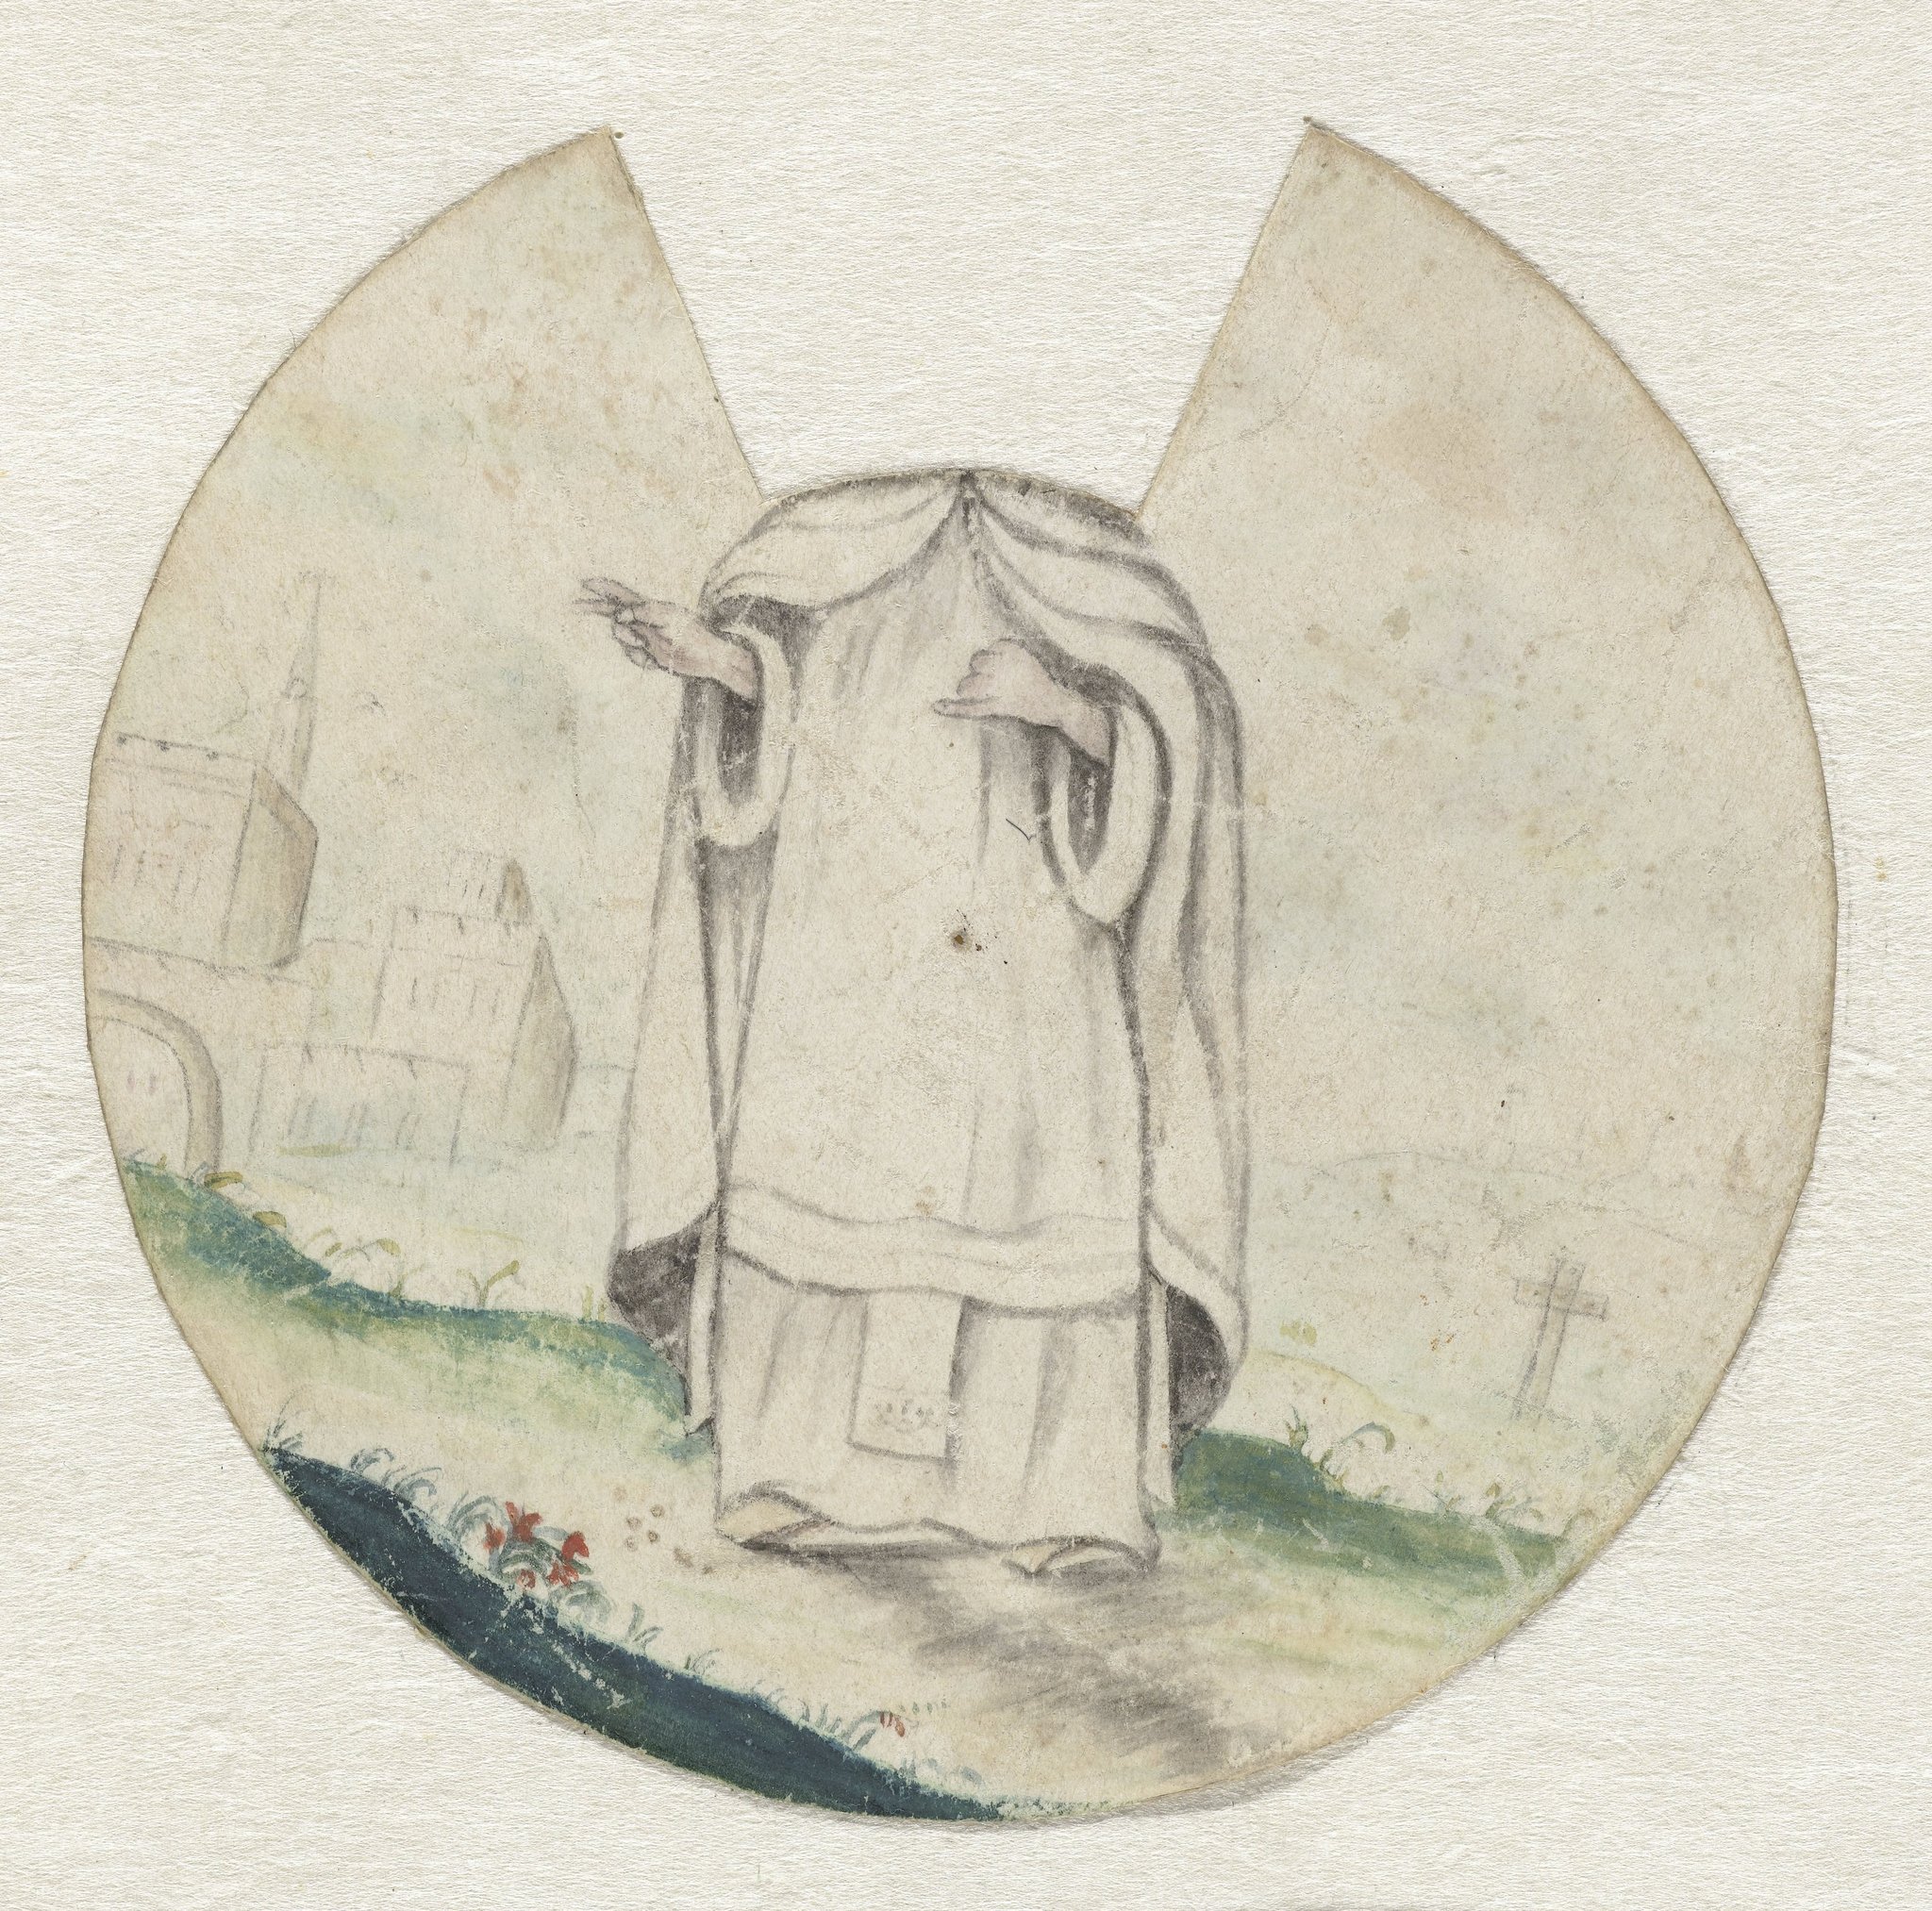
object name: drawing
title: Staande katholieke geestelijke die een zegenend gebaar maakt, zonder hoofd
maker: Anonymous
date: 1600-1699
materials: parchment, watercolor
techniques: brush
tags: abuses of the clergy, e.g. simony, organization, functionaries and dignitaries in roman catholic church; clergy in general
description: Staande katholieke geestelijke in een witte pij. Hij maakt een zegenend gebaar. Van het ronde blad is een stuk uitgesneden waardoor het hoofd ontbreekt. De tekening is een onderdeel van een combinatie van twee schijven, het andere draaischijf (met verschillende hoofden) ontbreekt. Anti-roomse satire voorstelling.